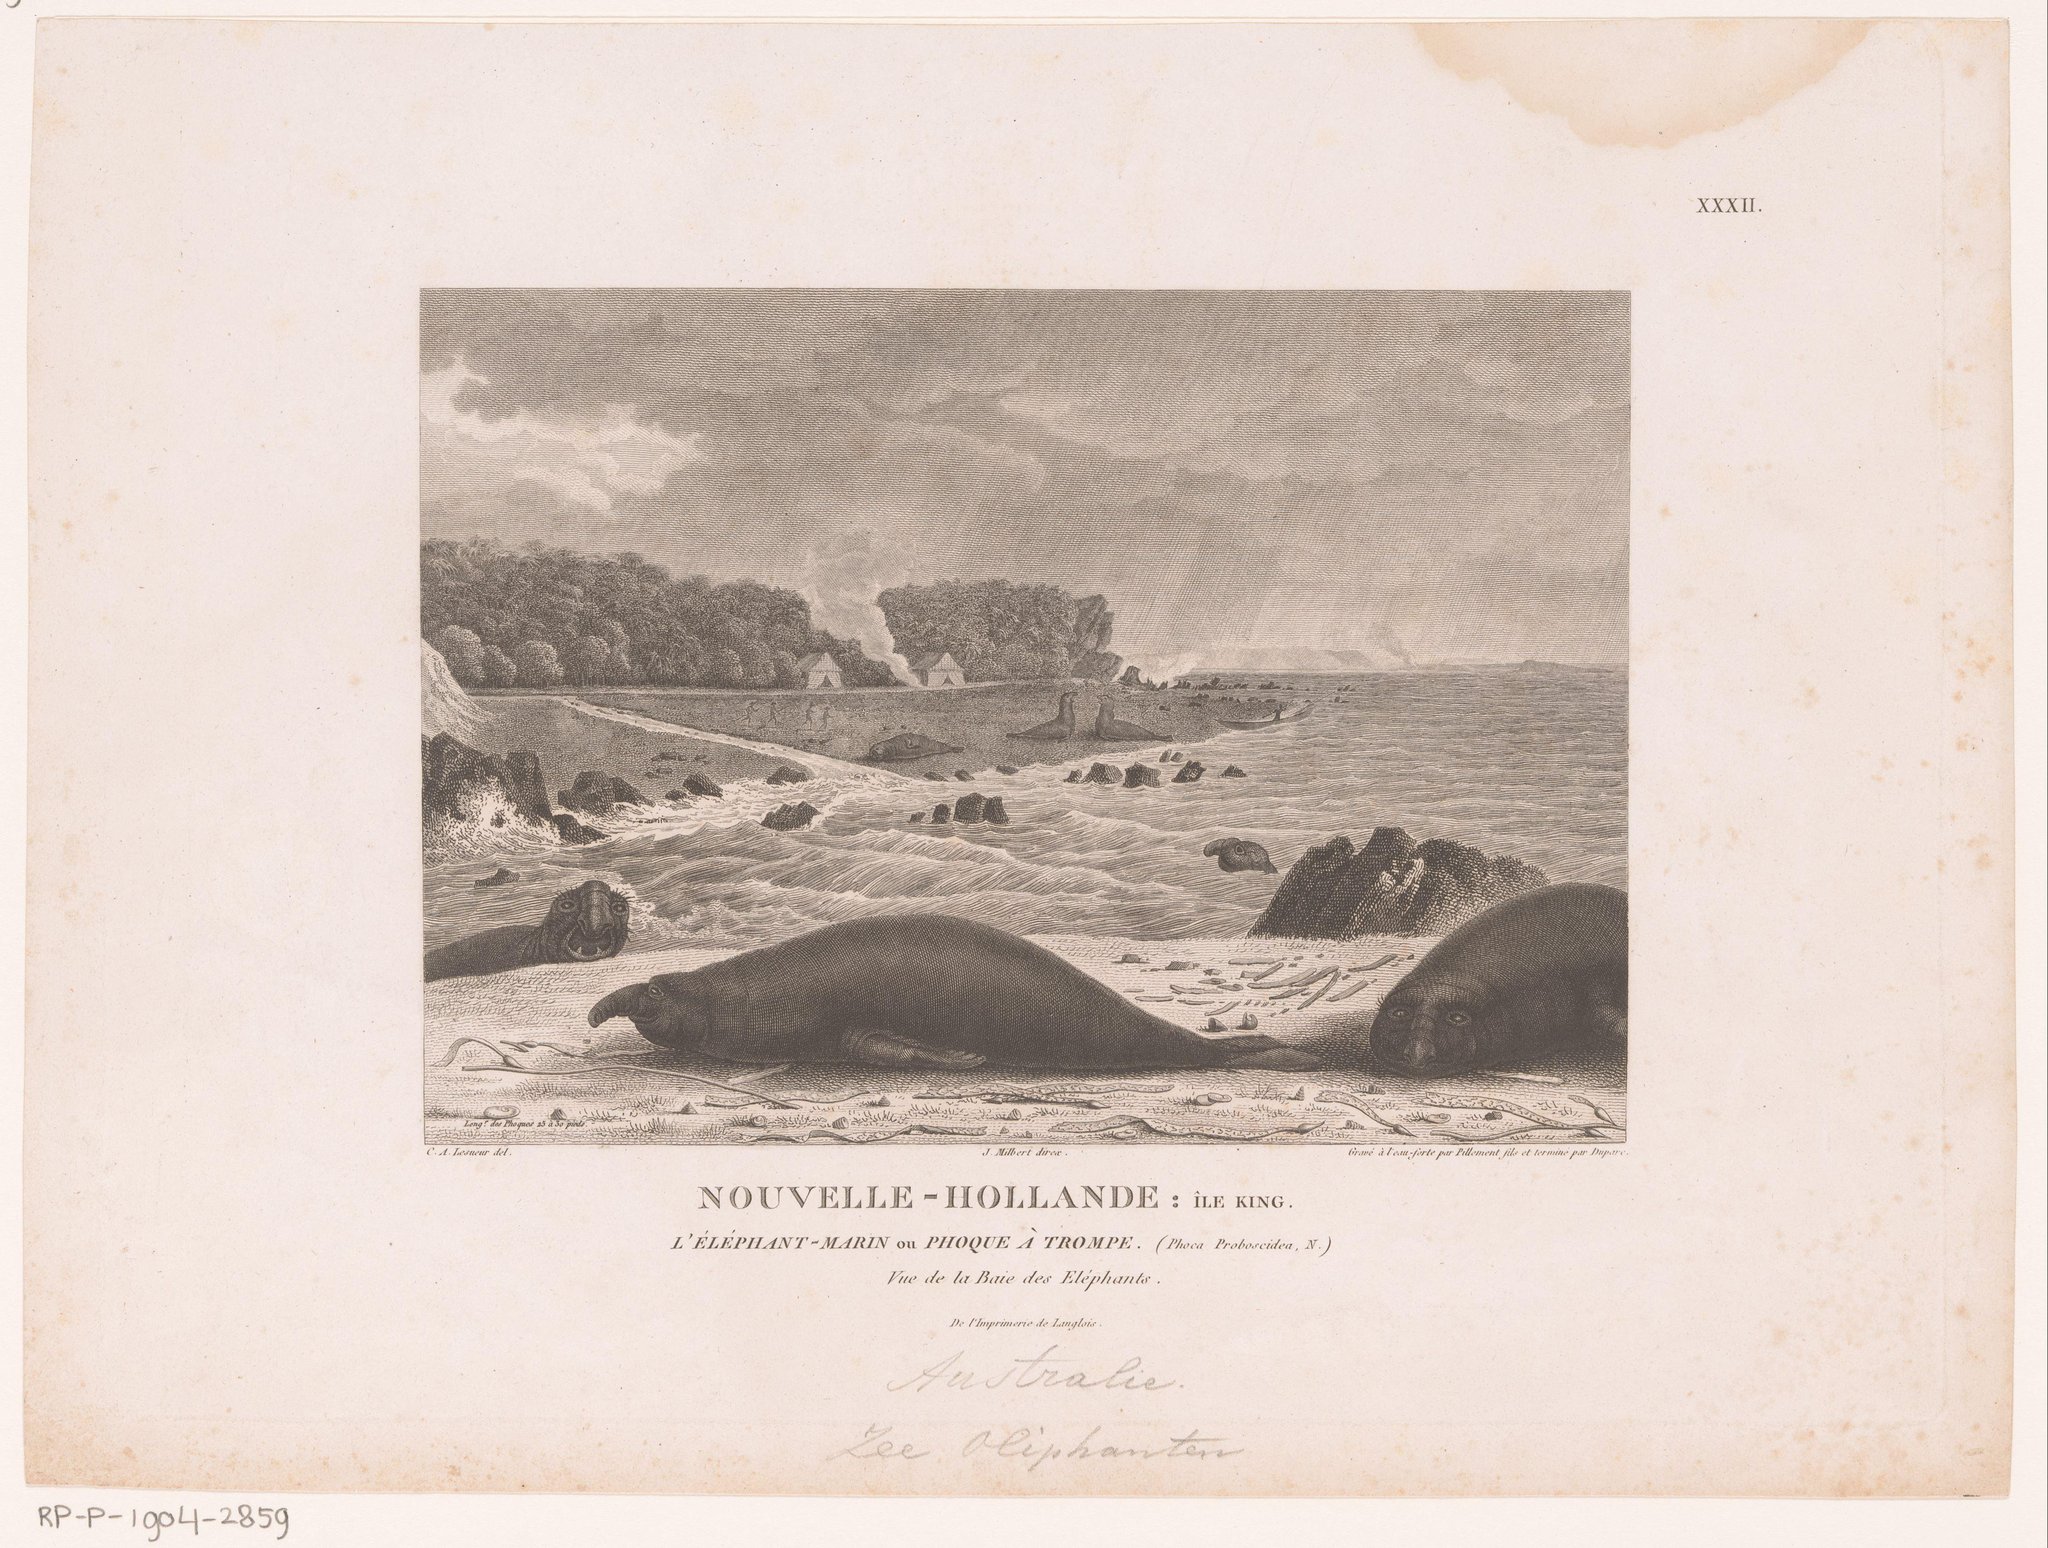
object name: print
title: Nouvelle-Hollande: Île King. L'éléphant-marin (...)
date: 1777-1814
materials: paper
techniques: etching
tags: swimming mammals: seal, australia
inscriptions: collector's mark: Lugt 2228